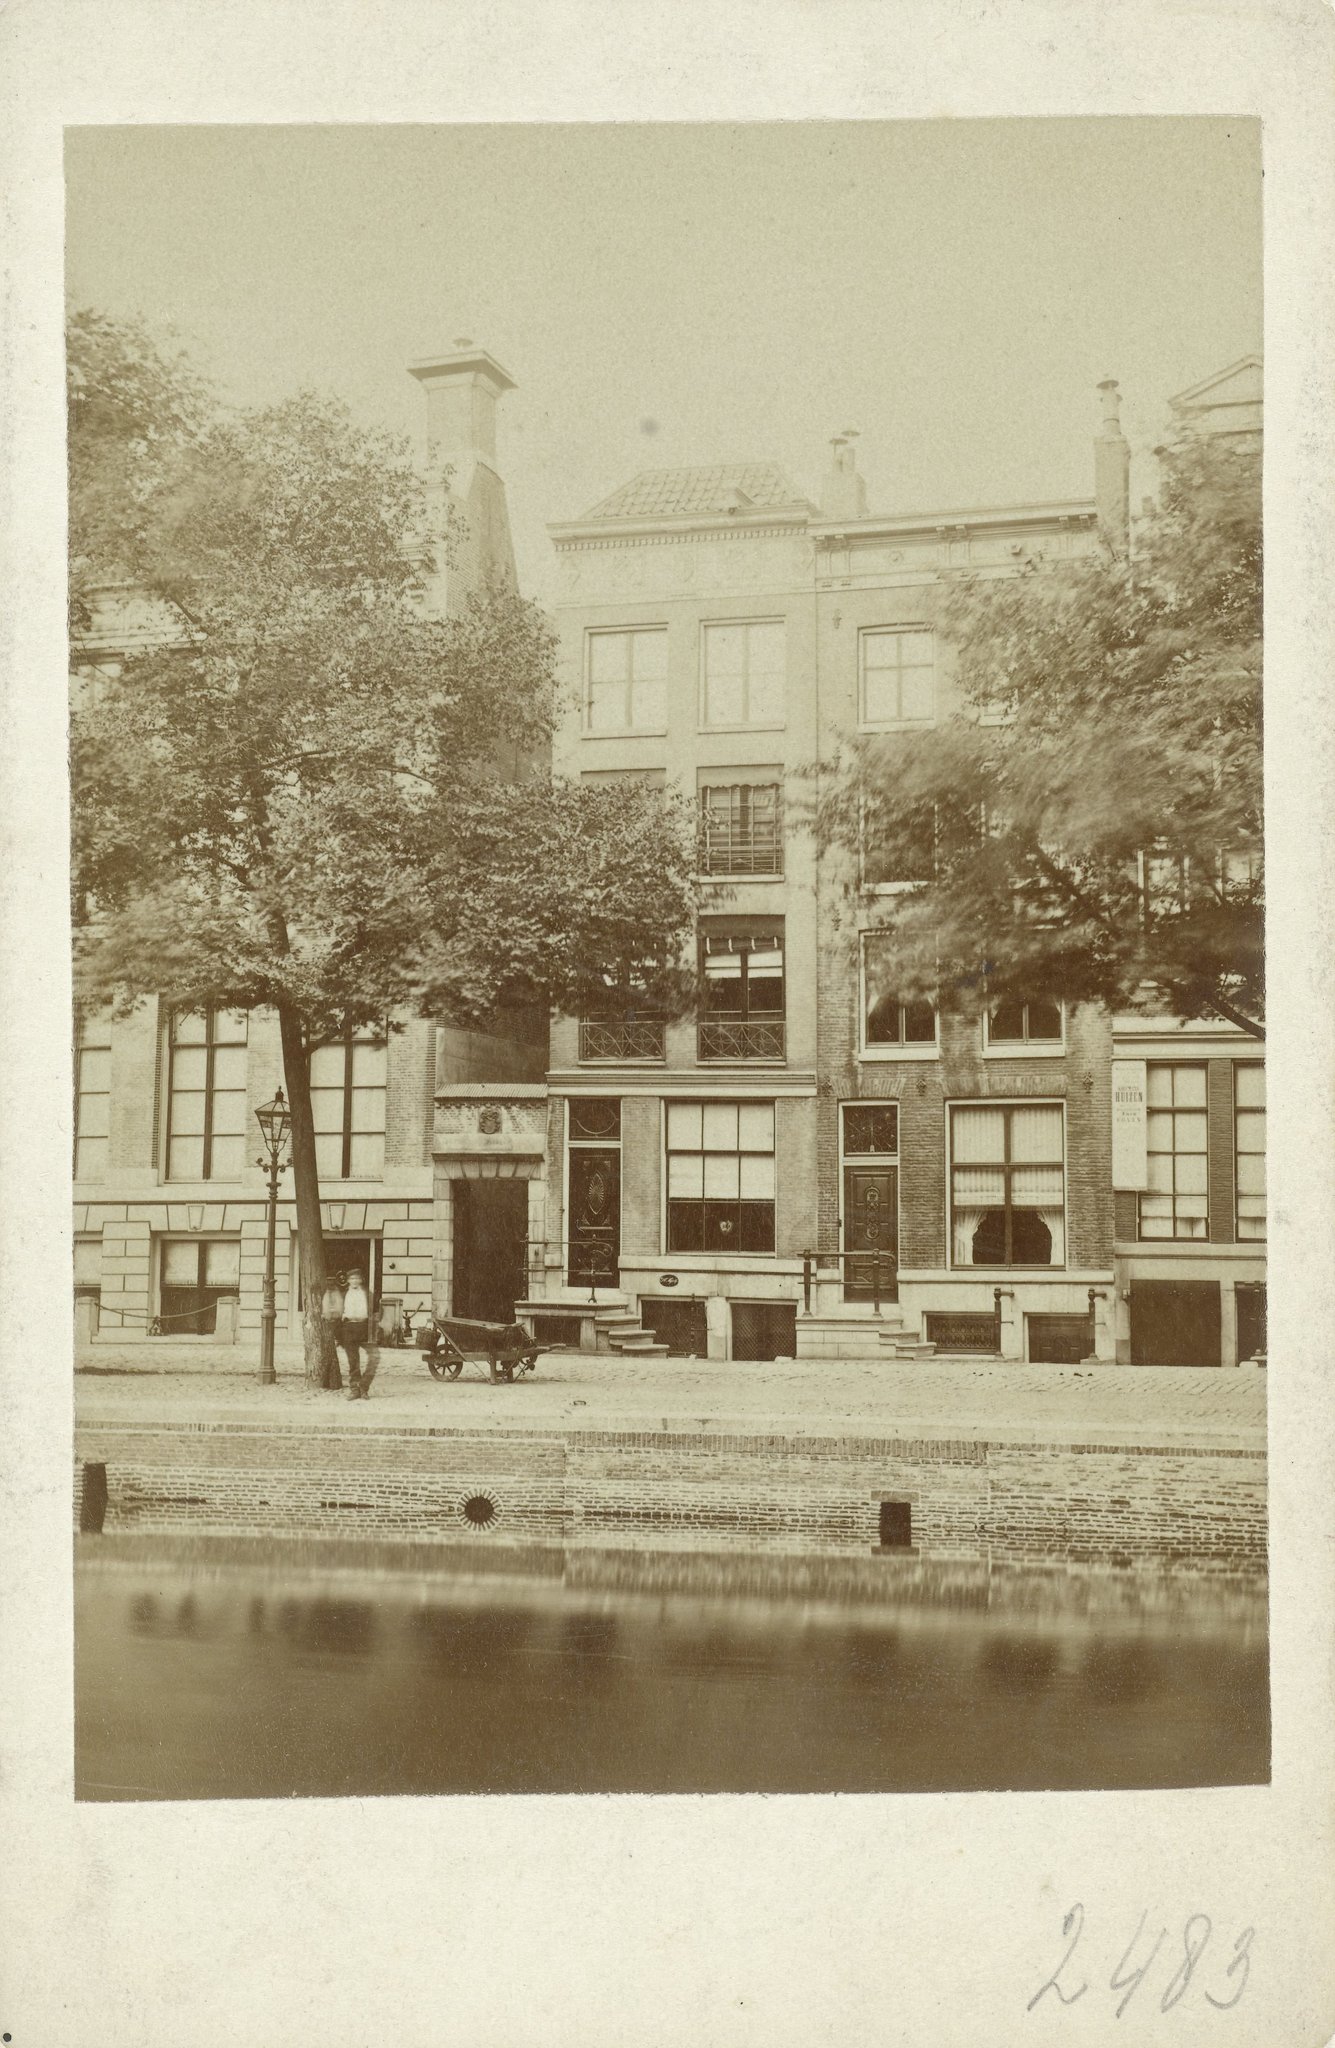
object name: cabinet photograph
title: Gezicht op Keizersgracht 332, woonhuis van het gezin Meijer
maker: Anonymous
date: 1870-1895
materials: cardboard, paper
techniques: albumen print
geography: amsterdam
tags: urban housing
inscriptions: number: ‘2483’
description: Keizersgracht 332 was het woonhuis van Dirk Christiaan Meijer (1798-1878), Willemina Hardenberg (1801-?) en hun kinderen. Na het overlijden van D.C. Meijer bleef zijn weduwe er voor onbekende tijd wonen. D.C. Meijer Jr. (1839-1908) woonde elders in Amsterdam.